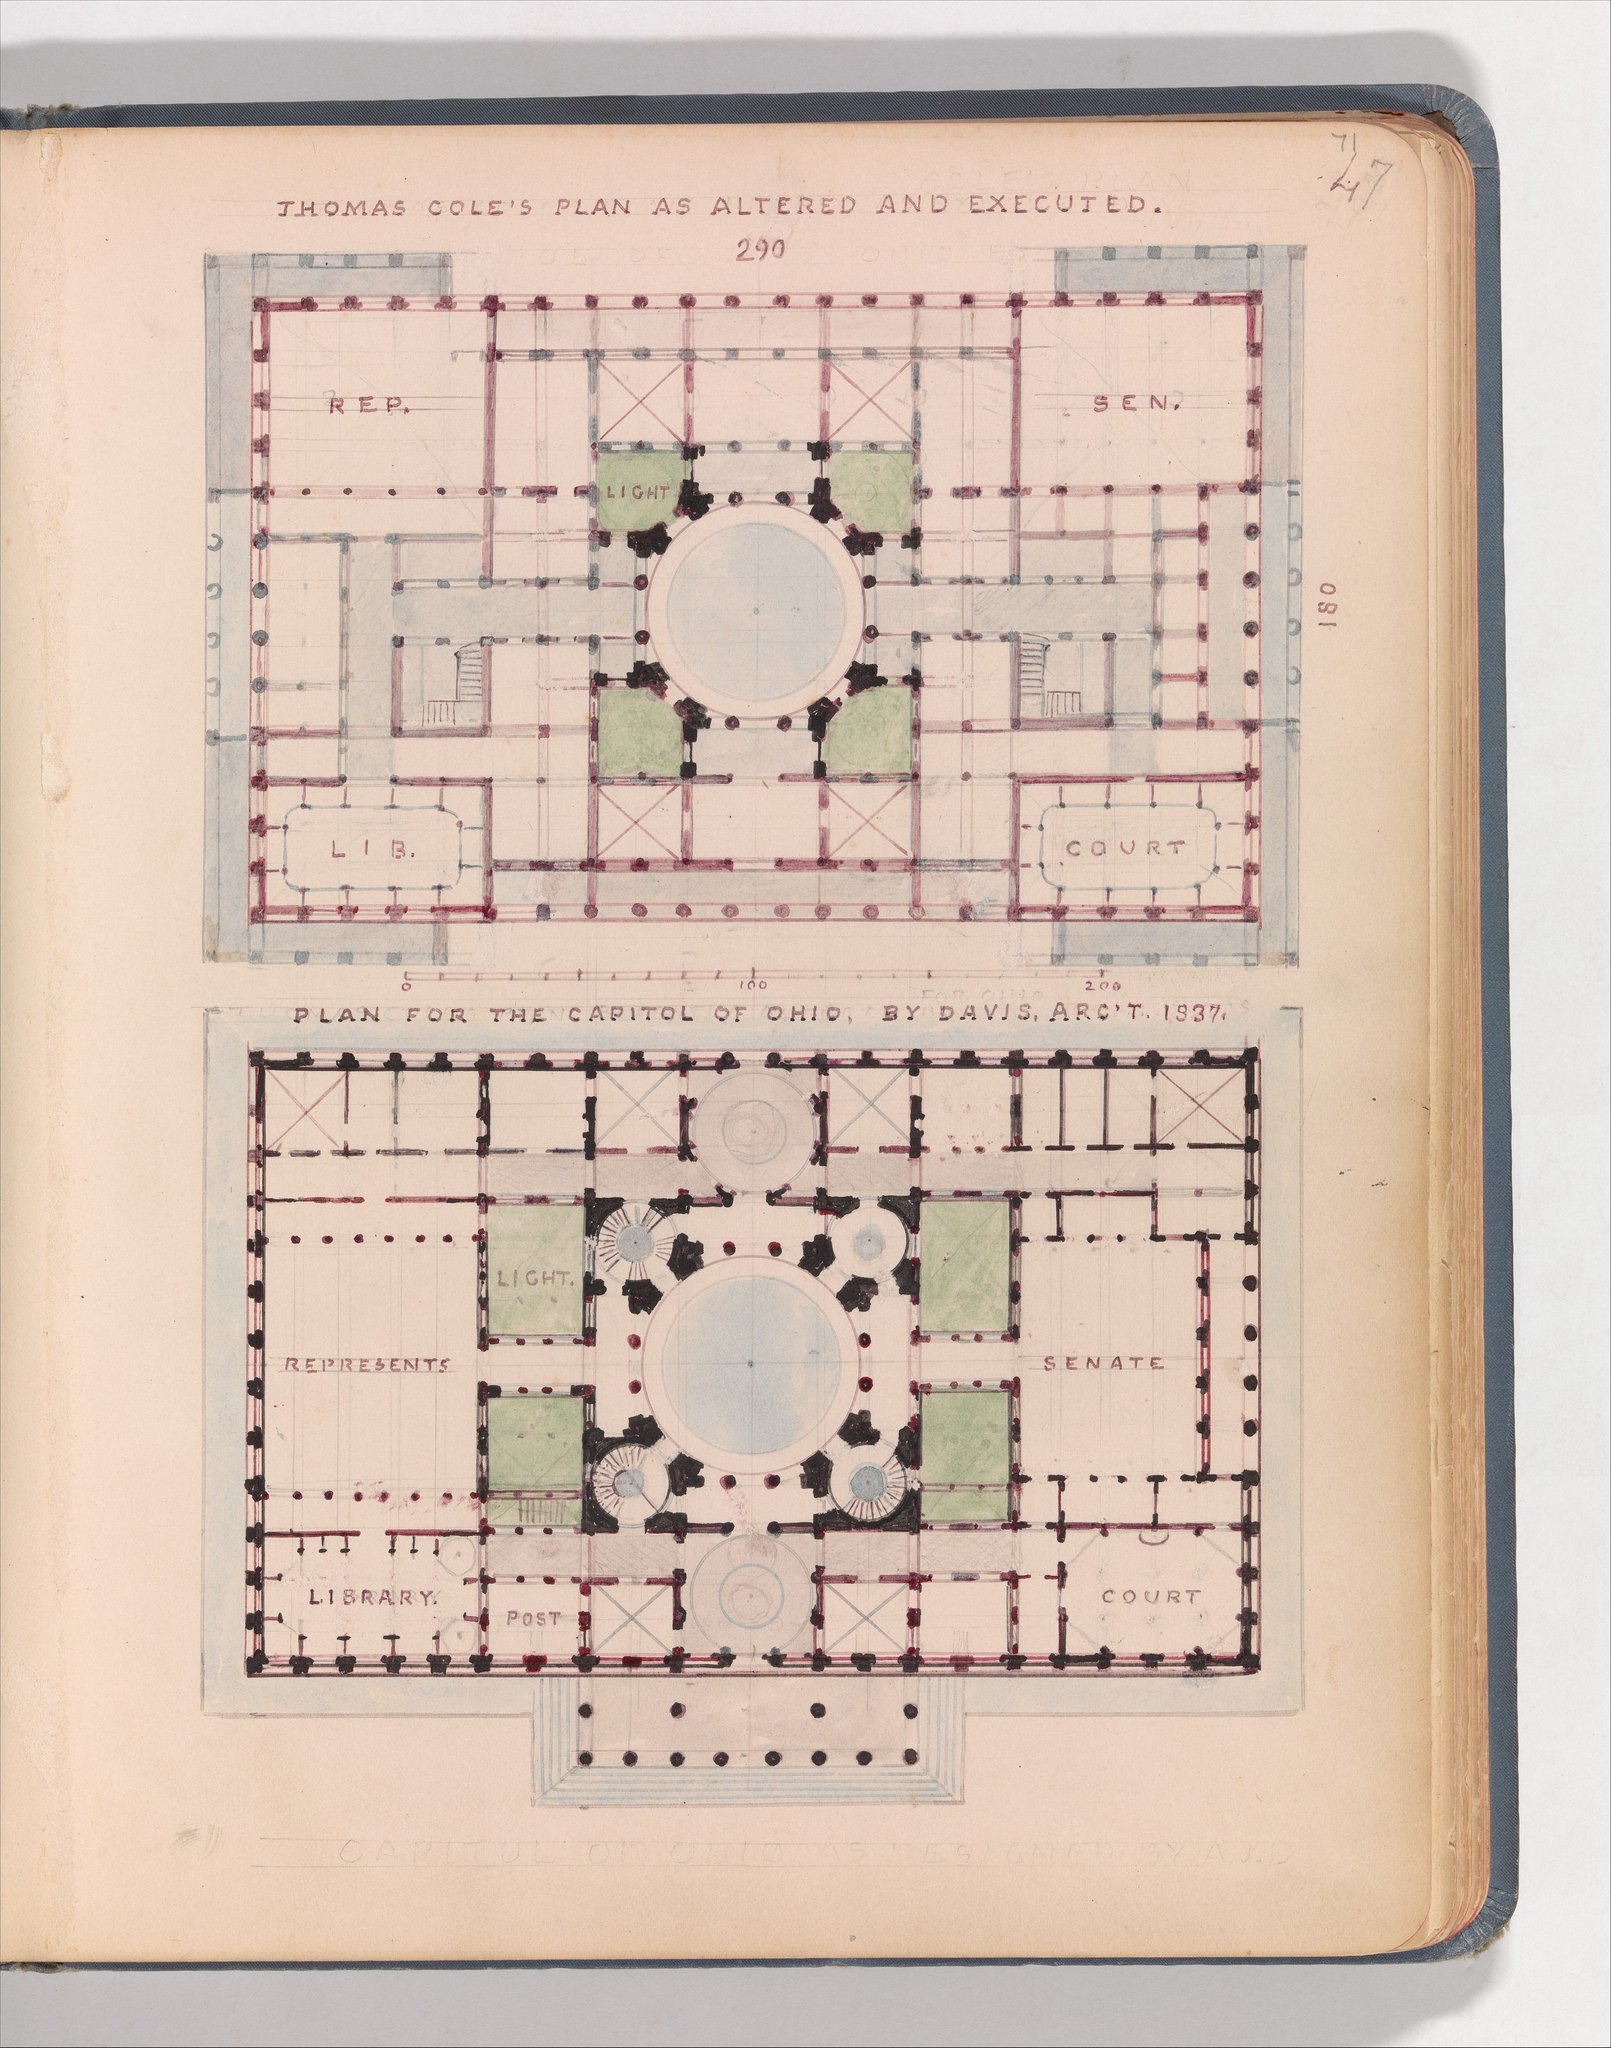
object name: drawing ornament architecture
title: Thomas Cole's Plan as Altered and Executed; and Plan for the Capitol of Ohio, by Davis, Arc't 1837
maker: alexander jackson davis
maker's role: artist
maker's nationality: american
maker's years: 1803-1892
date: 1837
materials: ink, watercolor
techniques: pen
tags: architecture